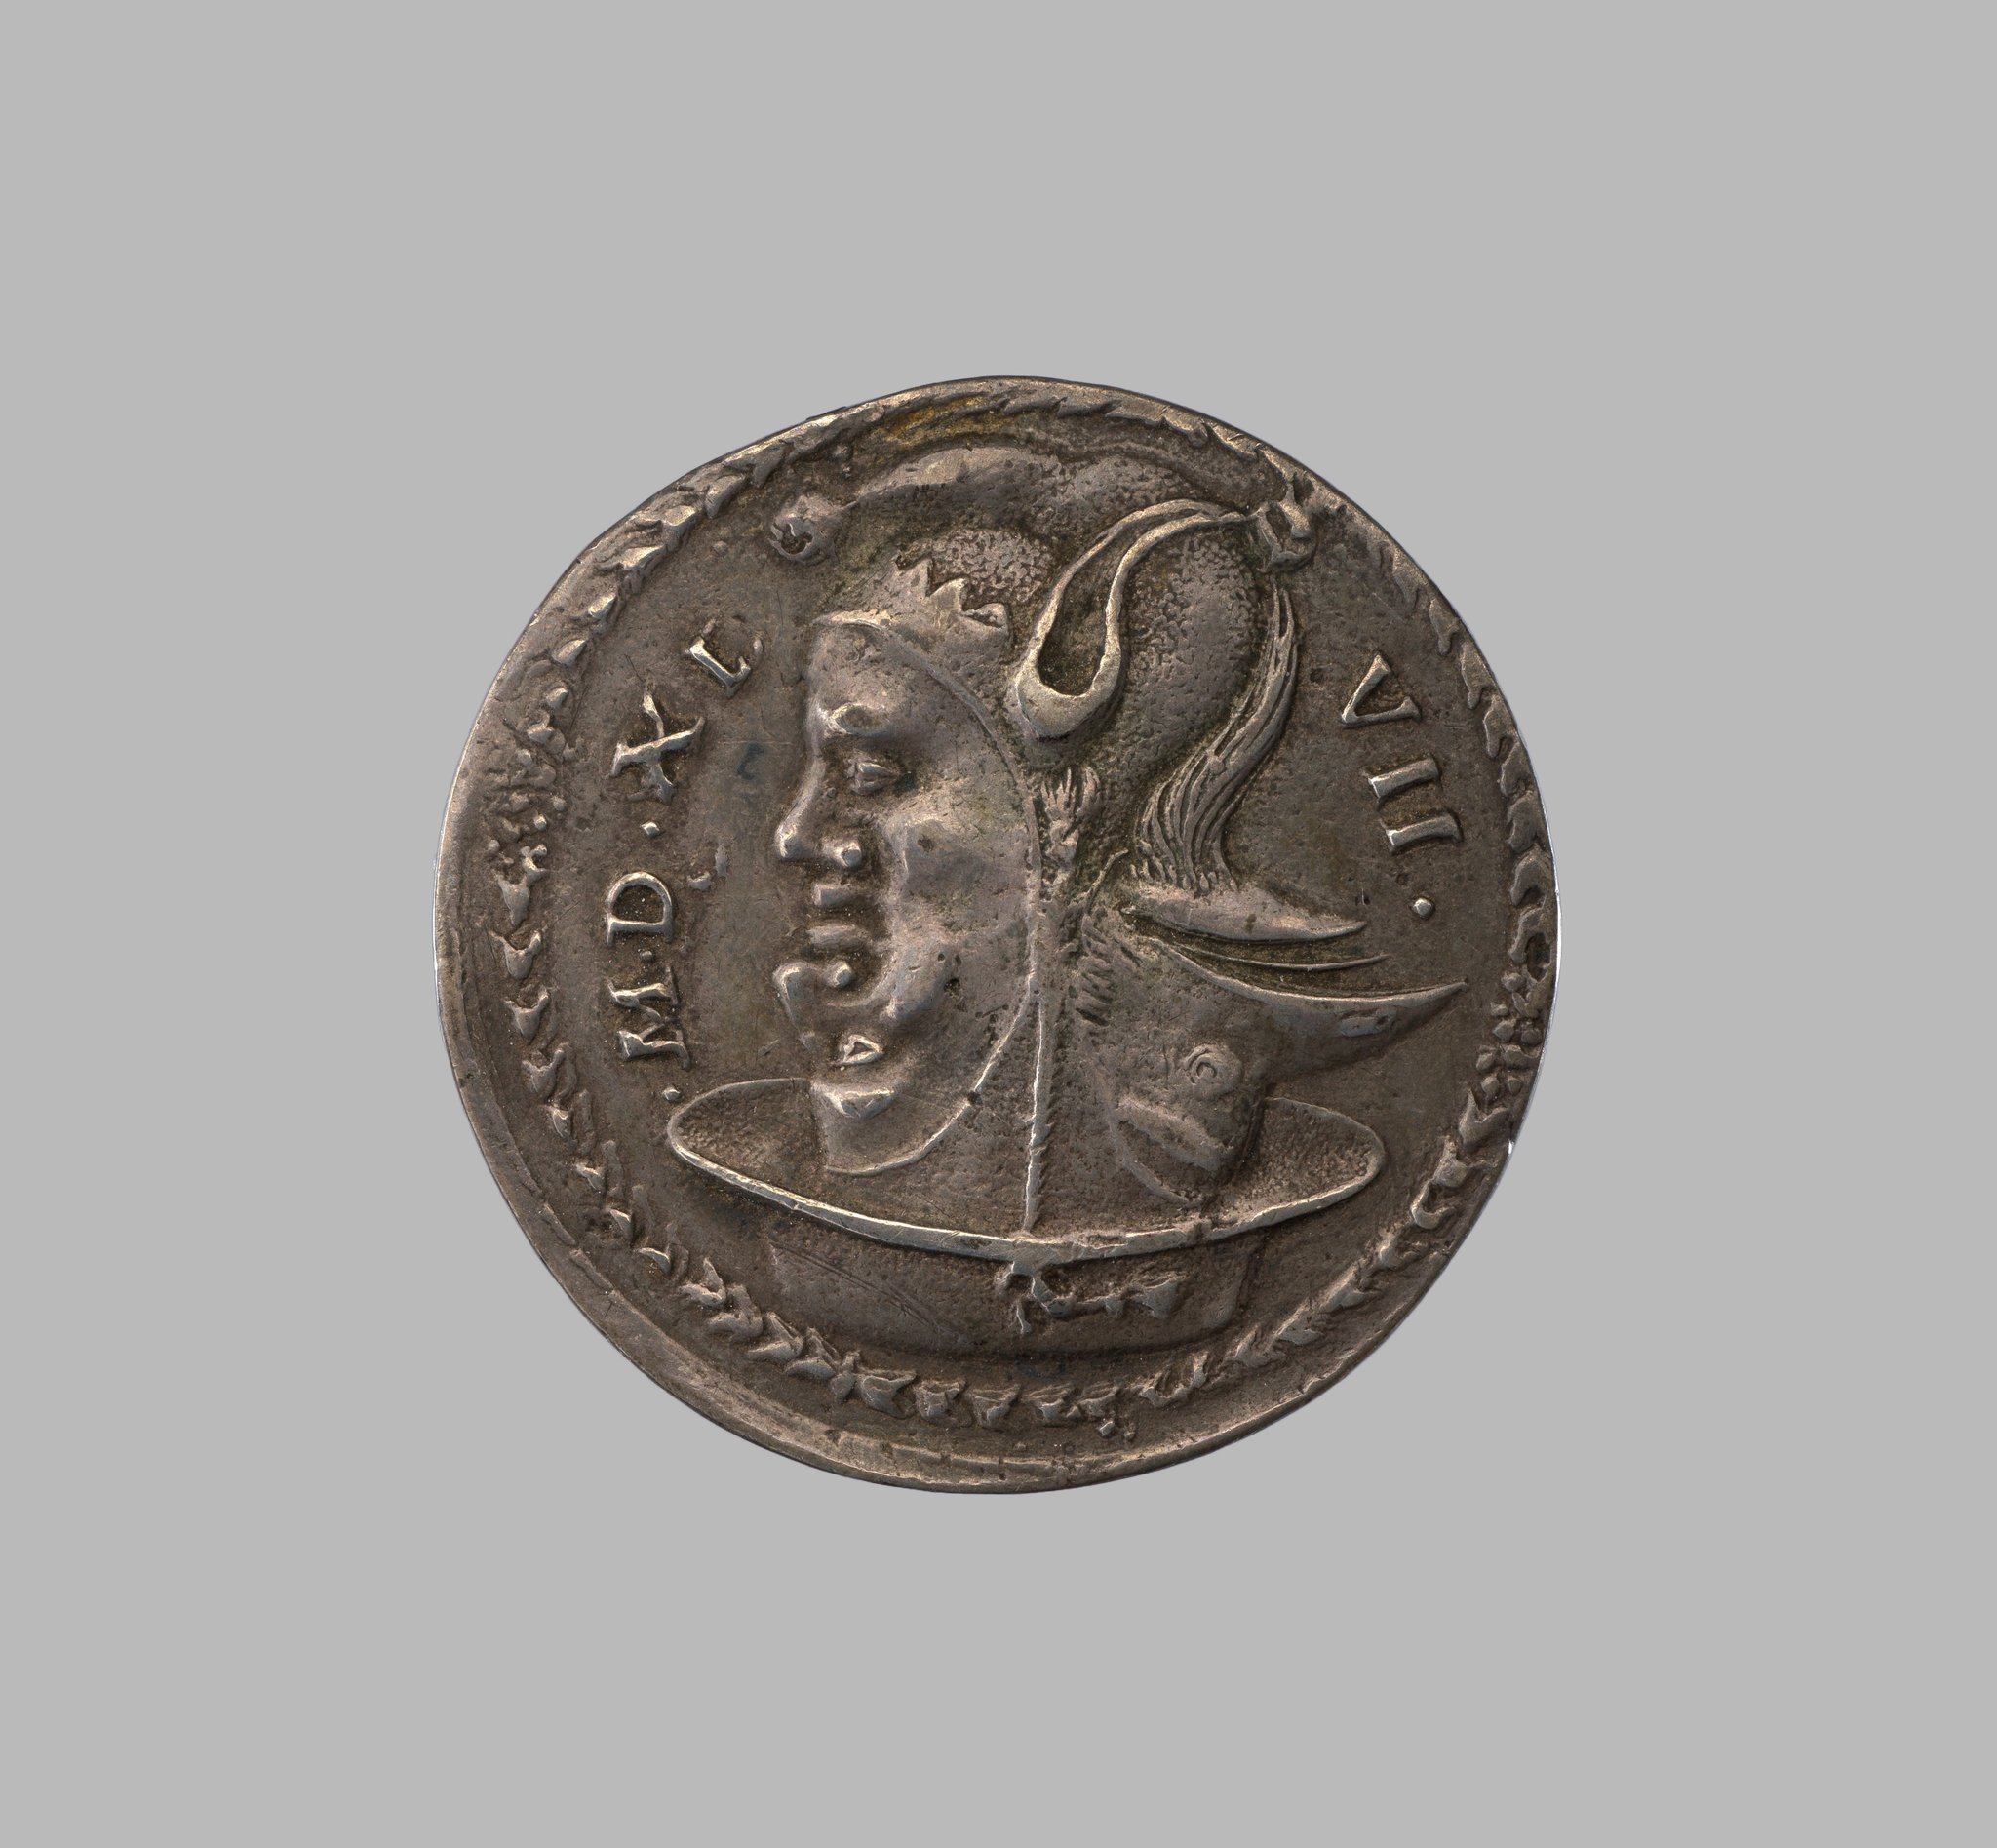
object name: medal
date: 1501-1600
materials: silver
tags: faces